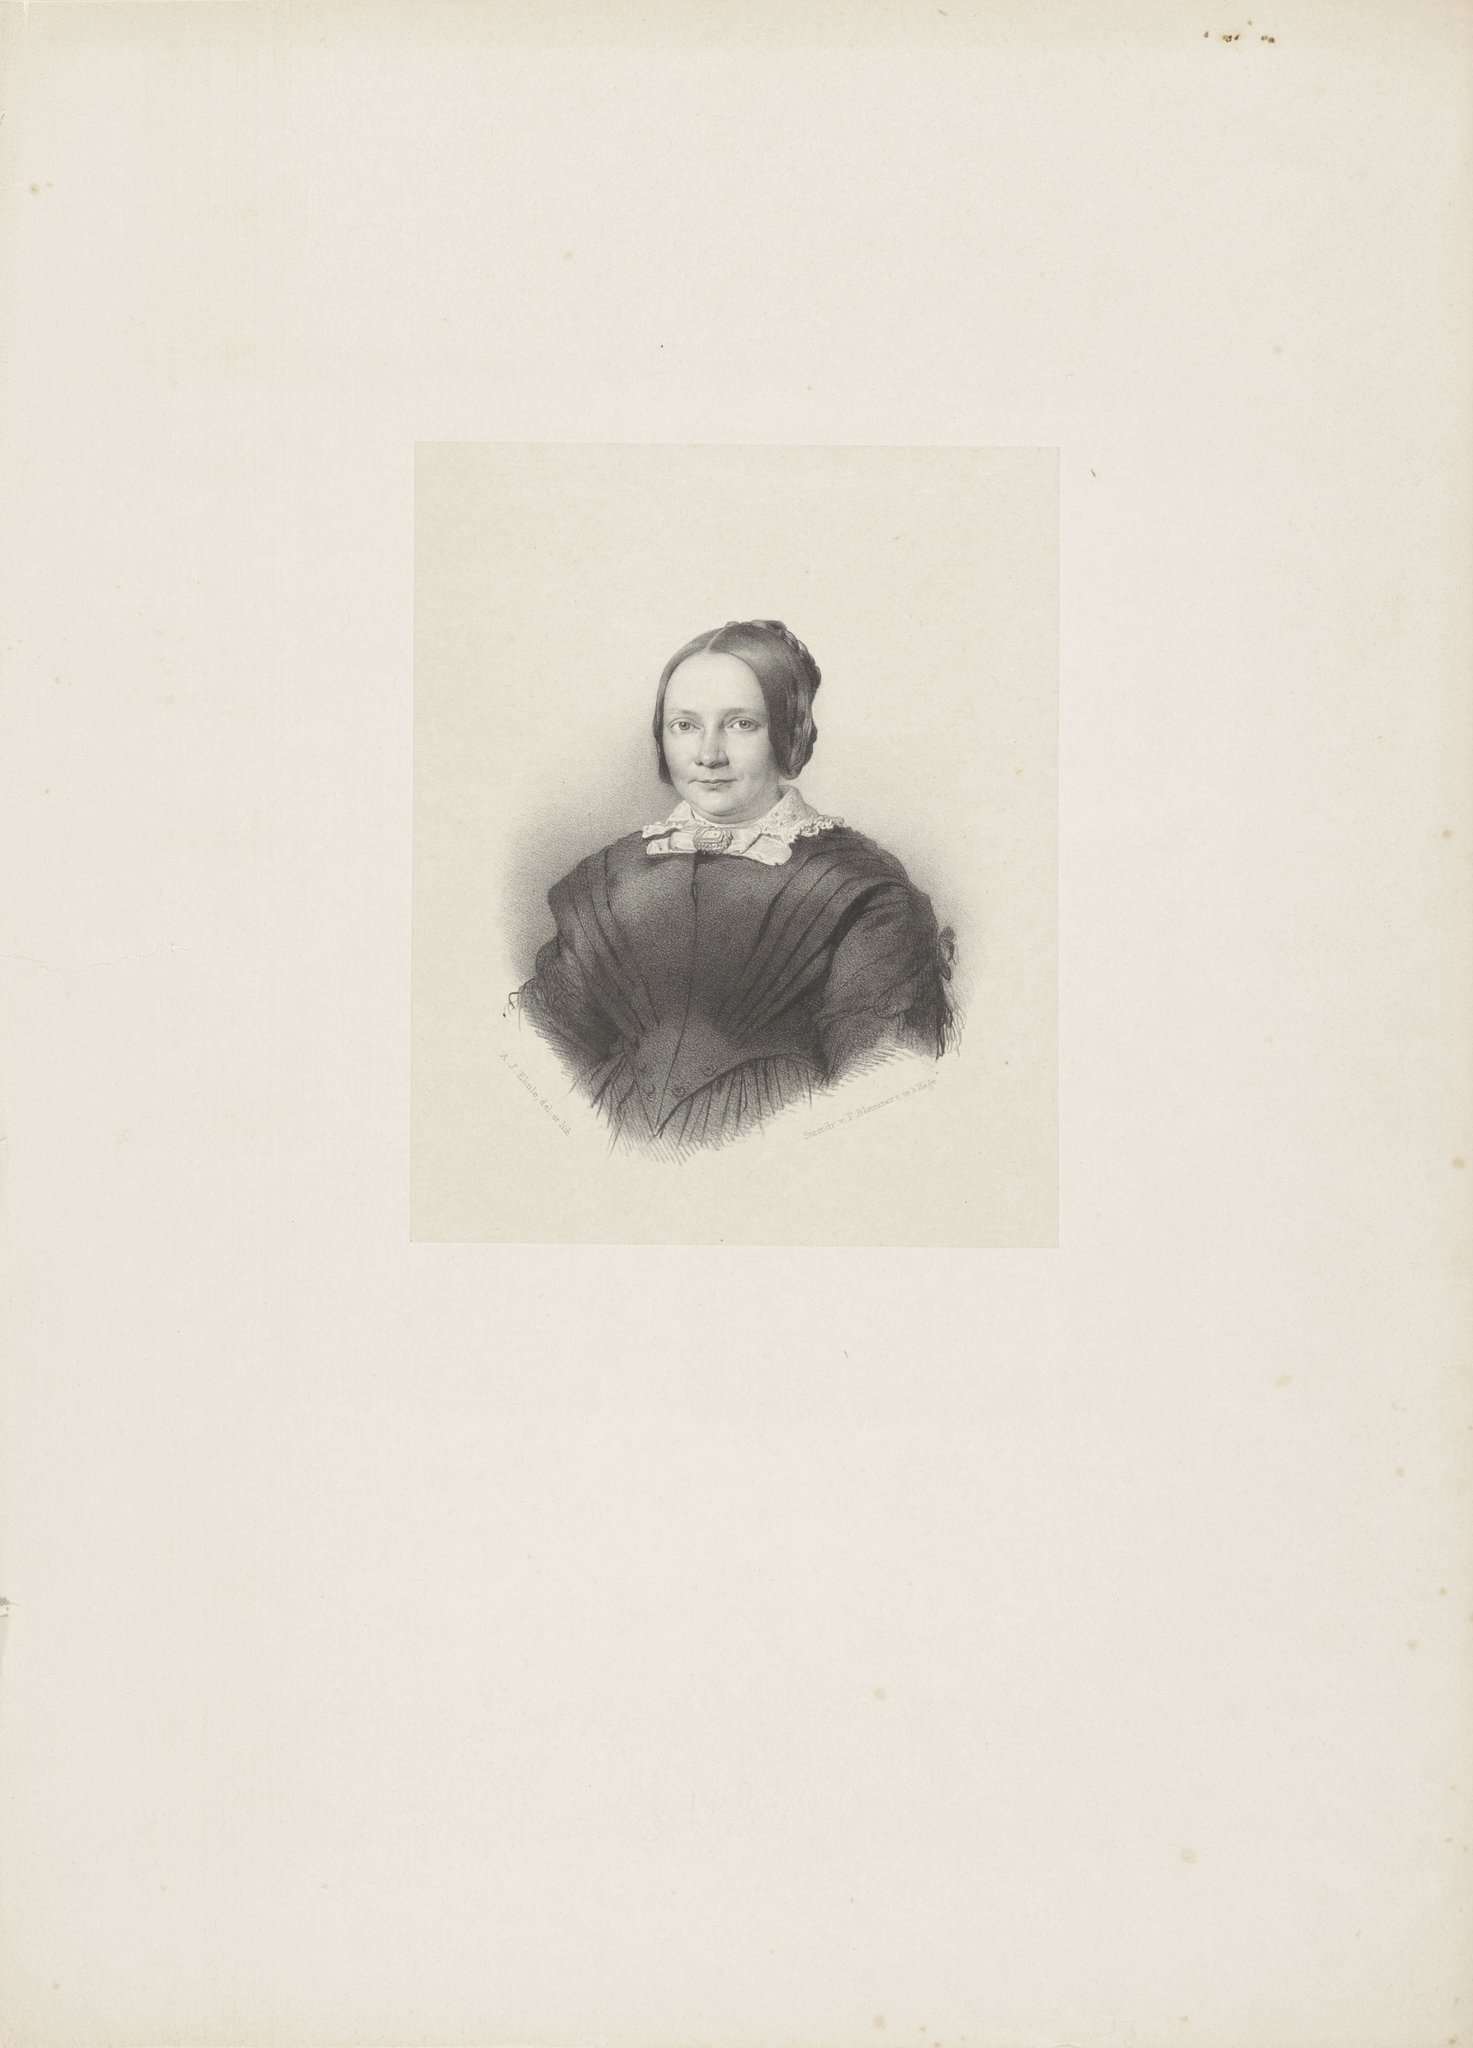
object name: print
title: Portret van Anna Louisa Geertruida Bosboom-Toussaint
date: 1842-1887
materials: paper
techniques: lithograph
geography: the hague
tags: historical persons (+ (full) bust portrait)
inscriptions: collector's mark: Lugt 2228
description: De geportretteerde draagt een donkere jurk met een kleine kanten kraag en een sierspeld.